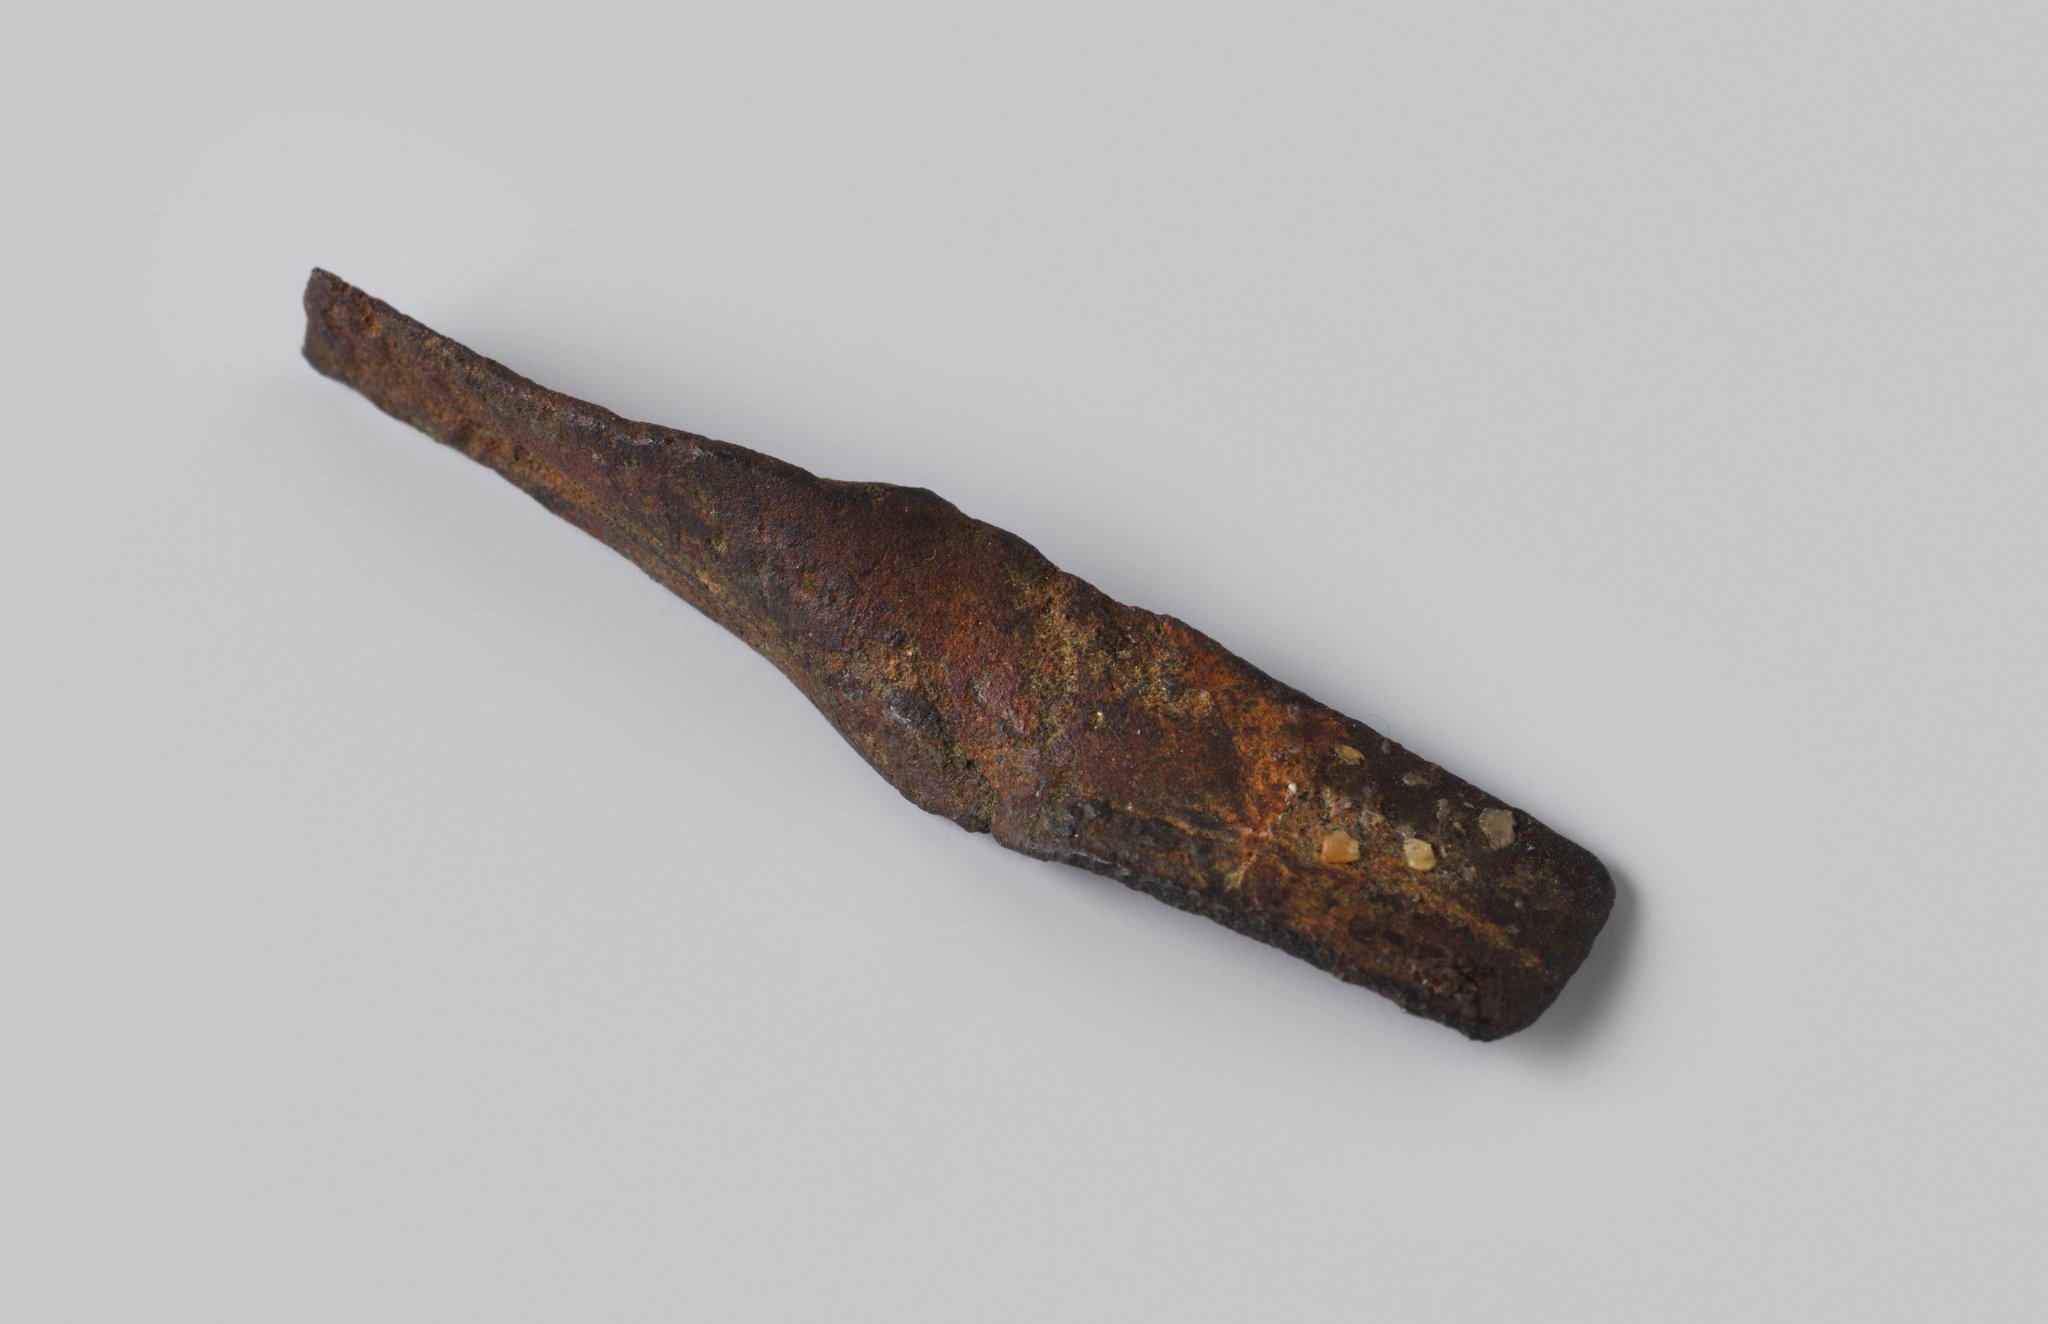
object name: fragment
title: Fragment gedraaide koperstrip uit het wrak van de Oost-Indiëvaarder Hollandia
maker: Anonymous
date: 1700-1743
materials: copper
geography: netherlands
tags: verenigde oostindische compagnie, hollandia (schip), annet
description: Varied parts or fragments, strips and strip-shaped fragments; fragm.